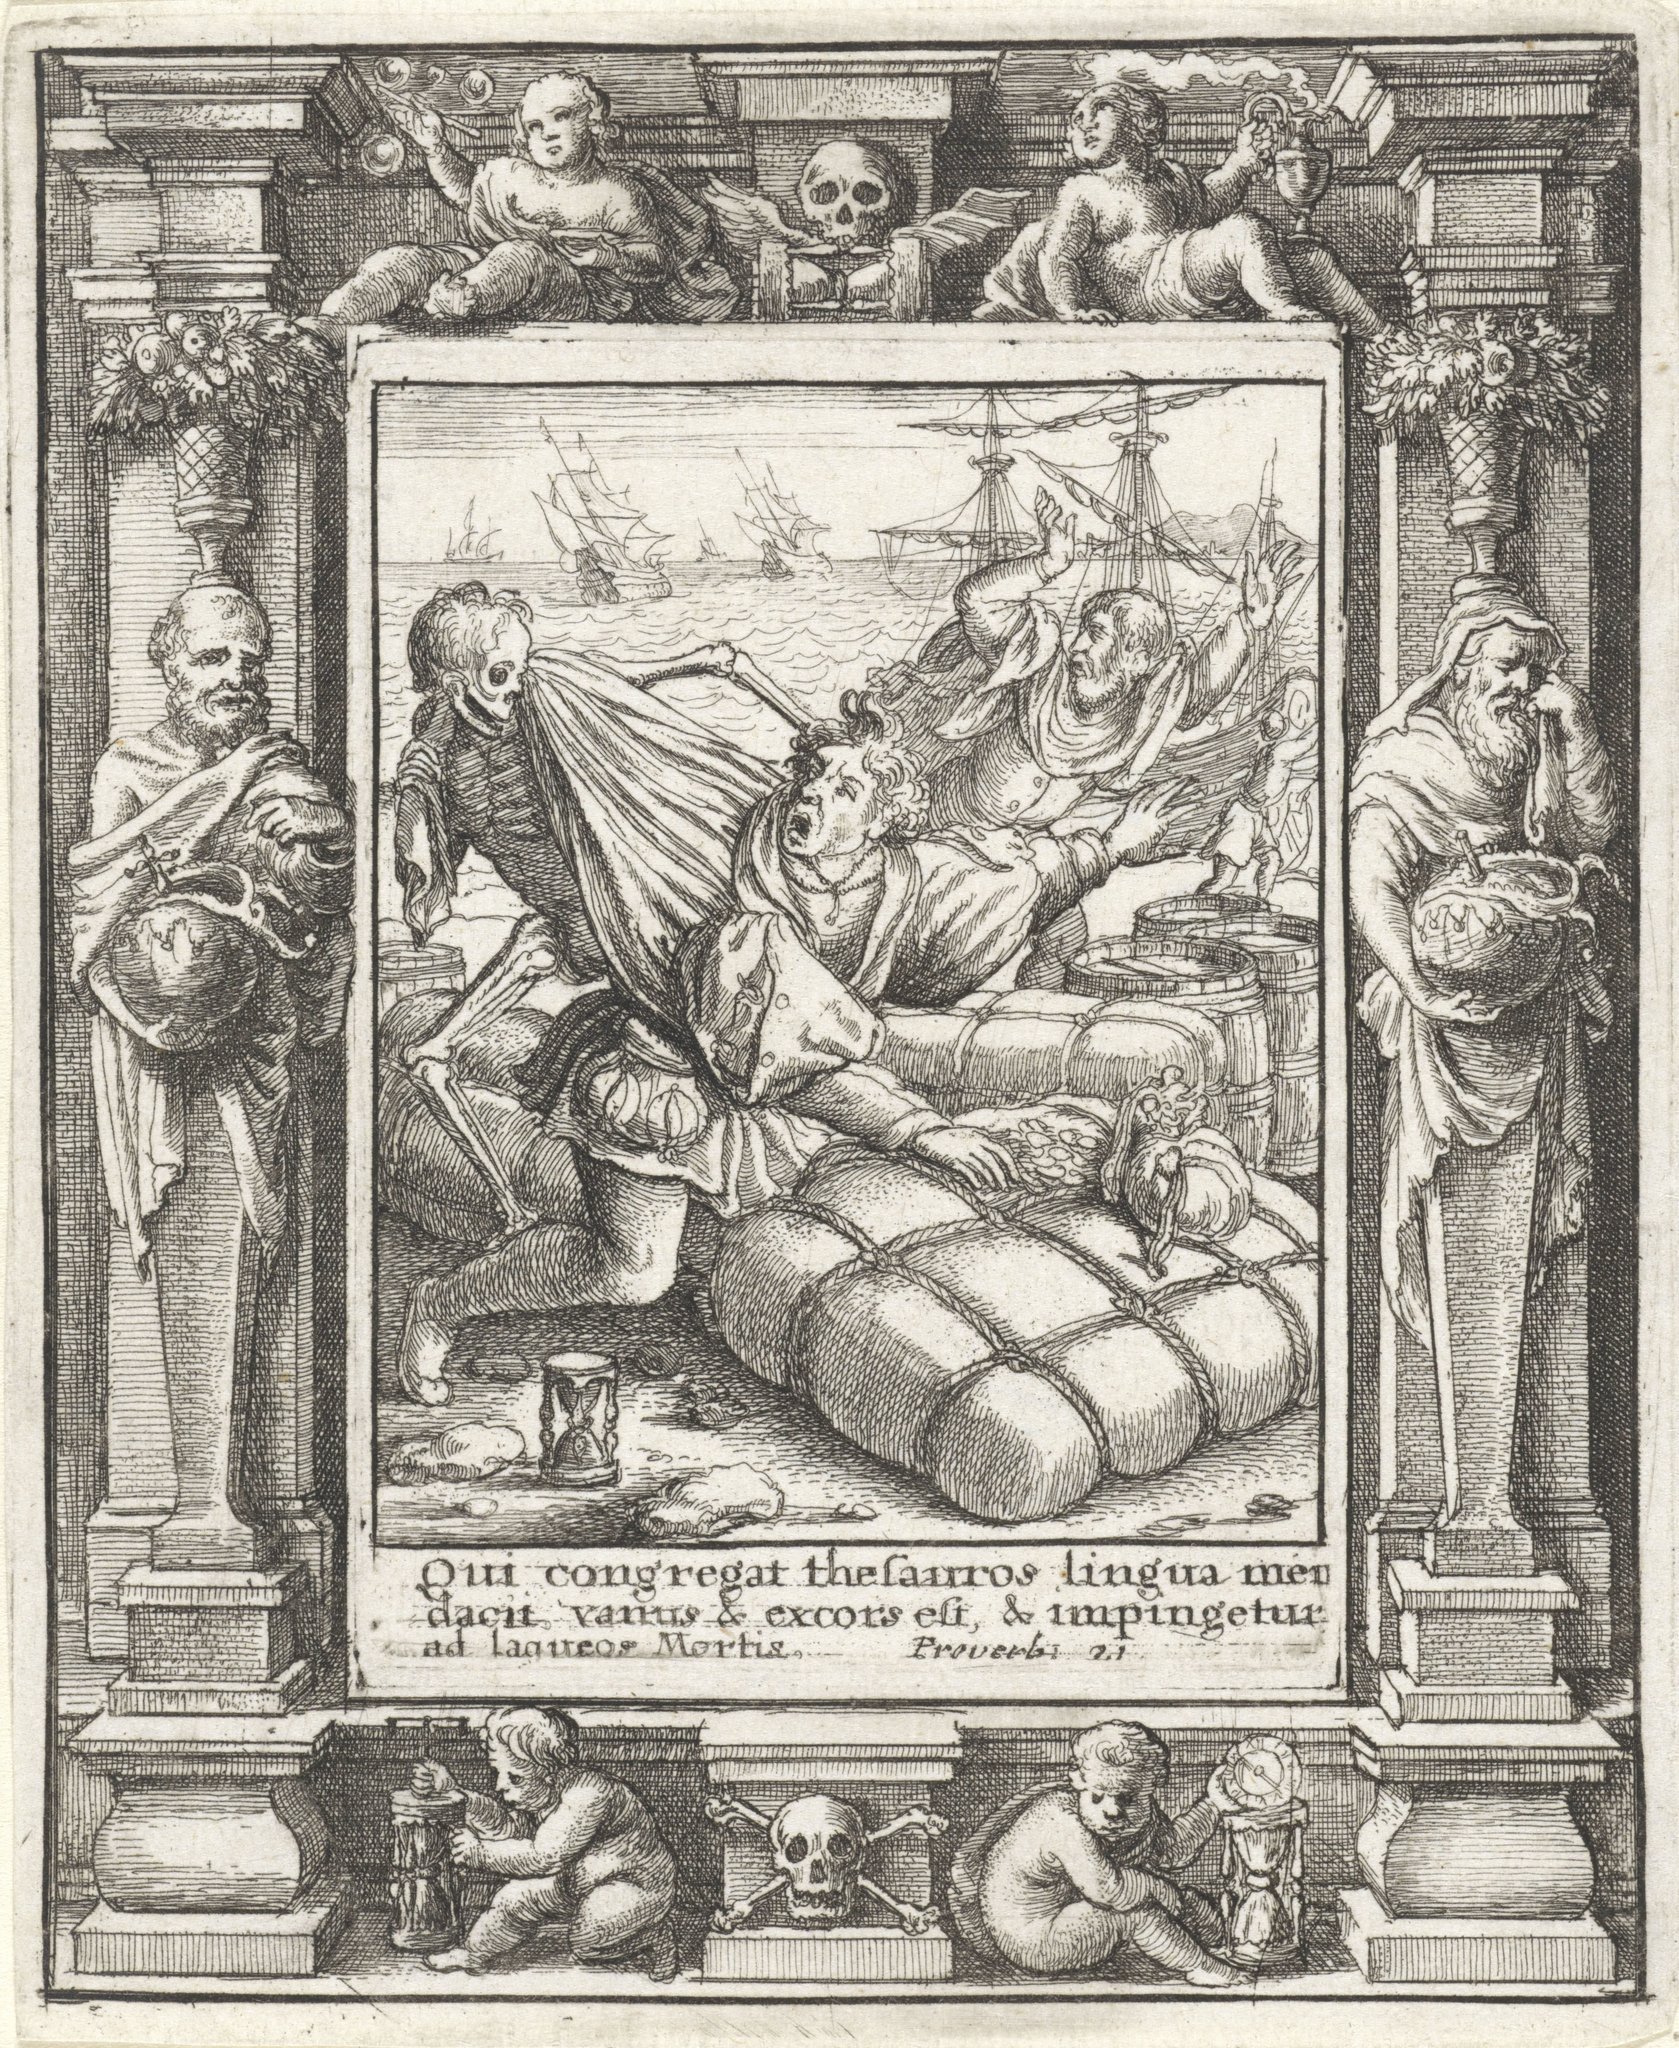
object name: print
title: De koopman en de Dood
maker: wenceslaus hollar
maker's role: draughtsman, print maker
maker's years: 1607-1677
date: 1651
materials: paper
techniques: etching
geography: antwerp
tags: dance of death; death together with one or more human beings, (story of) heraclitus, the philosopher, (story of) democritus, the philosopher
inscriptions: collector's mark: Lugt 2228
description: Een koopman bij de haven telt zijn geld op een bundel koopwaar. De Dood trekt hem aan zijn jasje. 23ste prent uit een reeks van 30 dodendansprenten; met een omlijsting met Democritus en Heraclitus.